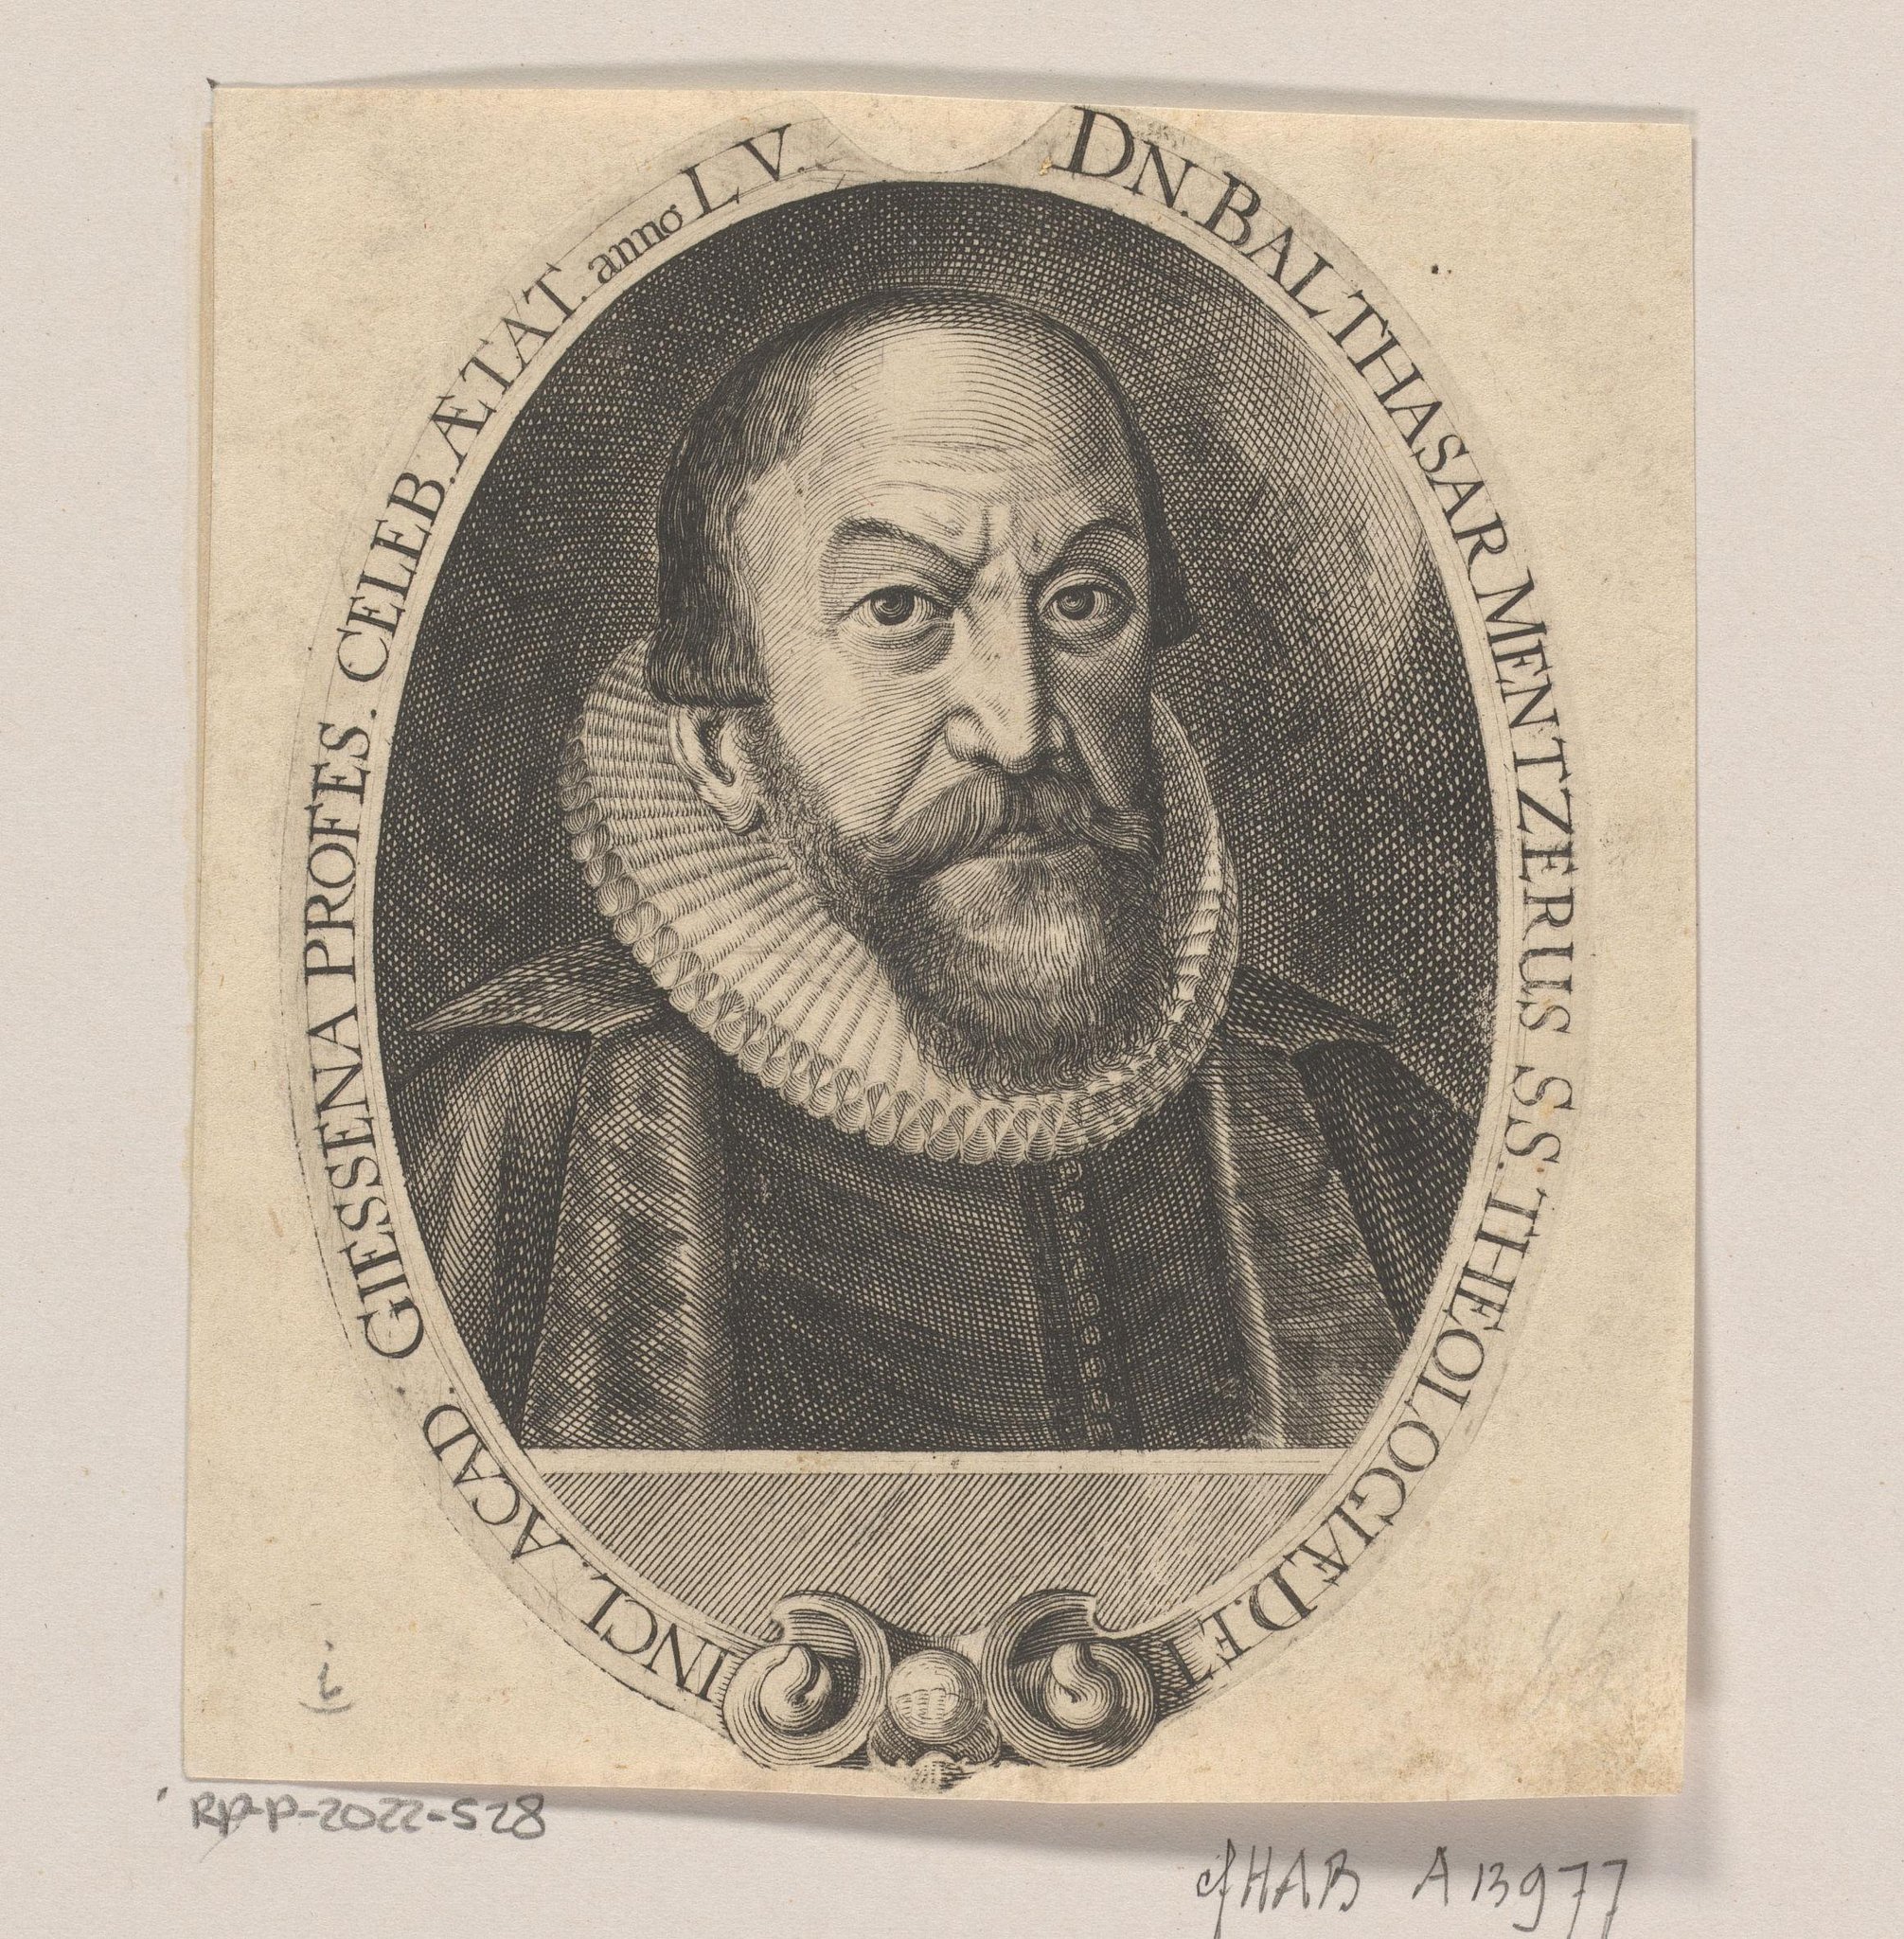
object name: print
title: Dn. Balthasar Mentzerus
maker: peter isselburg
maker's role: print maker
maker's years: 1568-1630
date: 1616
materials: paper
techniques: engraving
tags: theologian, historical persons